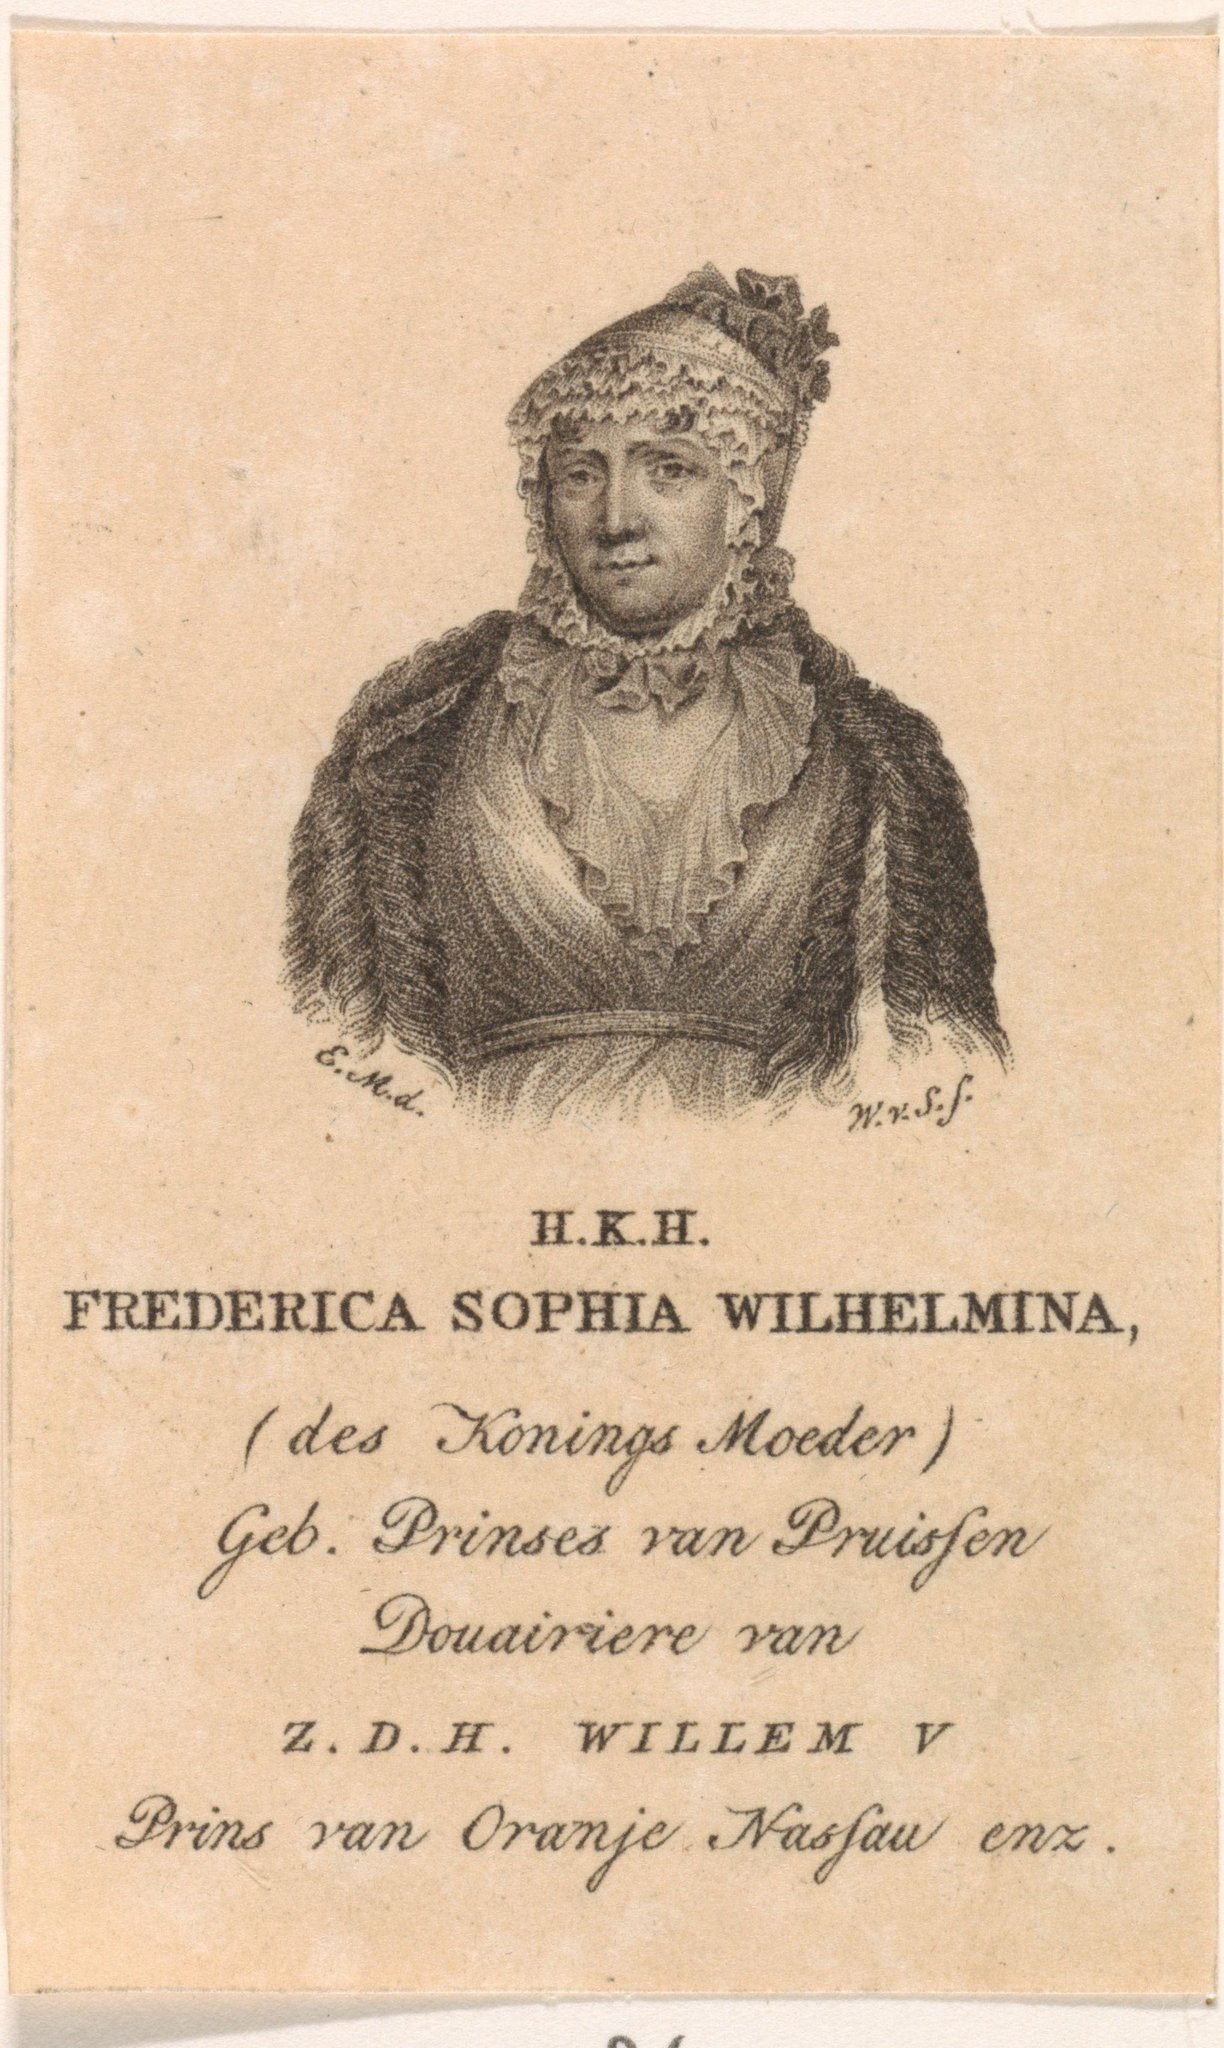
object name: print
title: Portret van Wilhelmina van Pruisen (1751-1820)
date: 1783-1851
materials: paper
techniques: etching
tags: berlin, painter, draughtsman, wilhelmina of prussia (princess of orange)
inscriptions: collector's mark: Lugt 2228